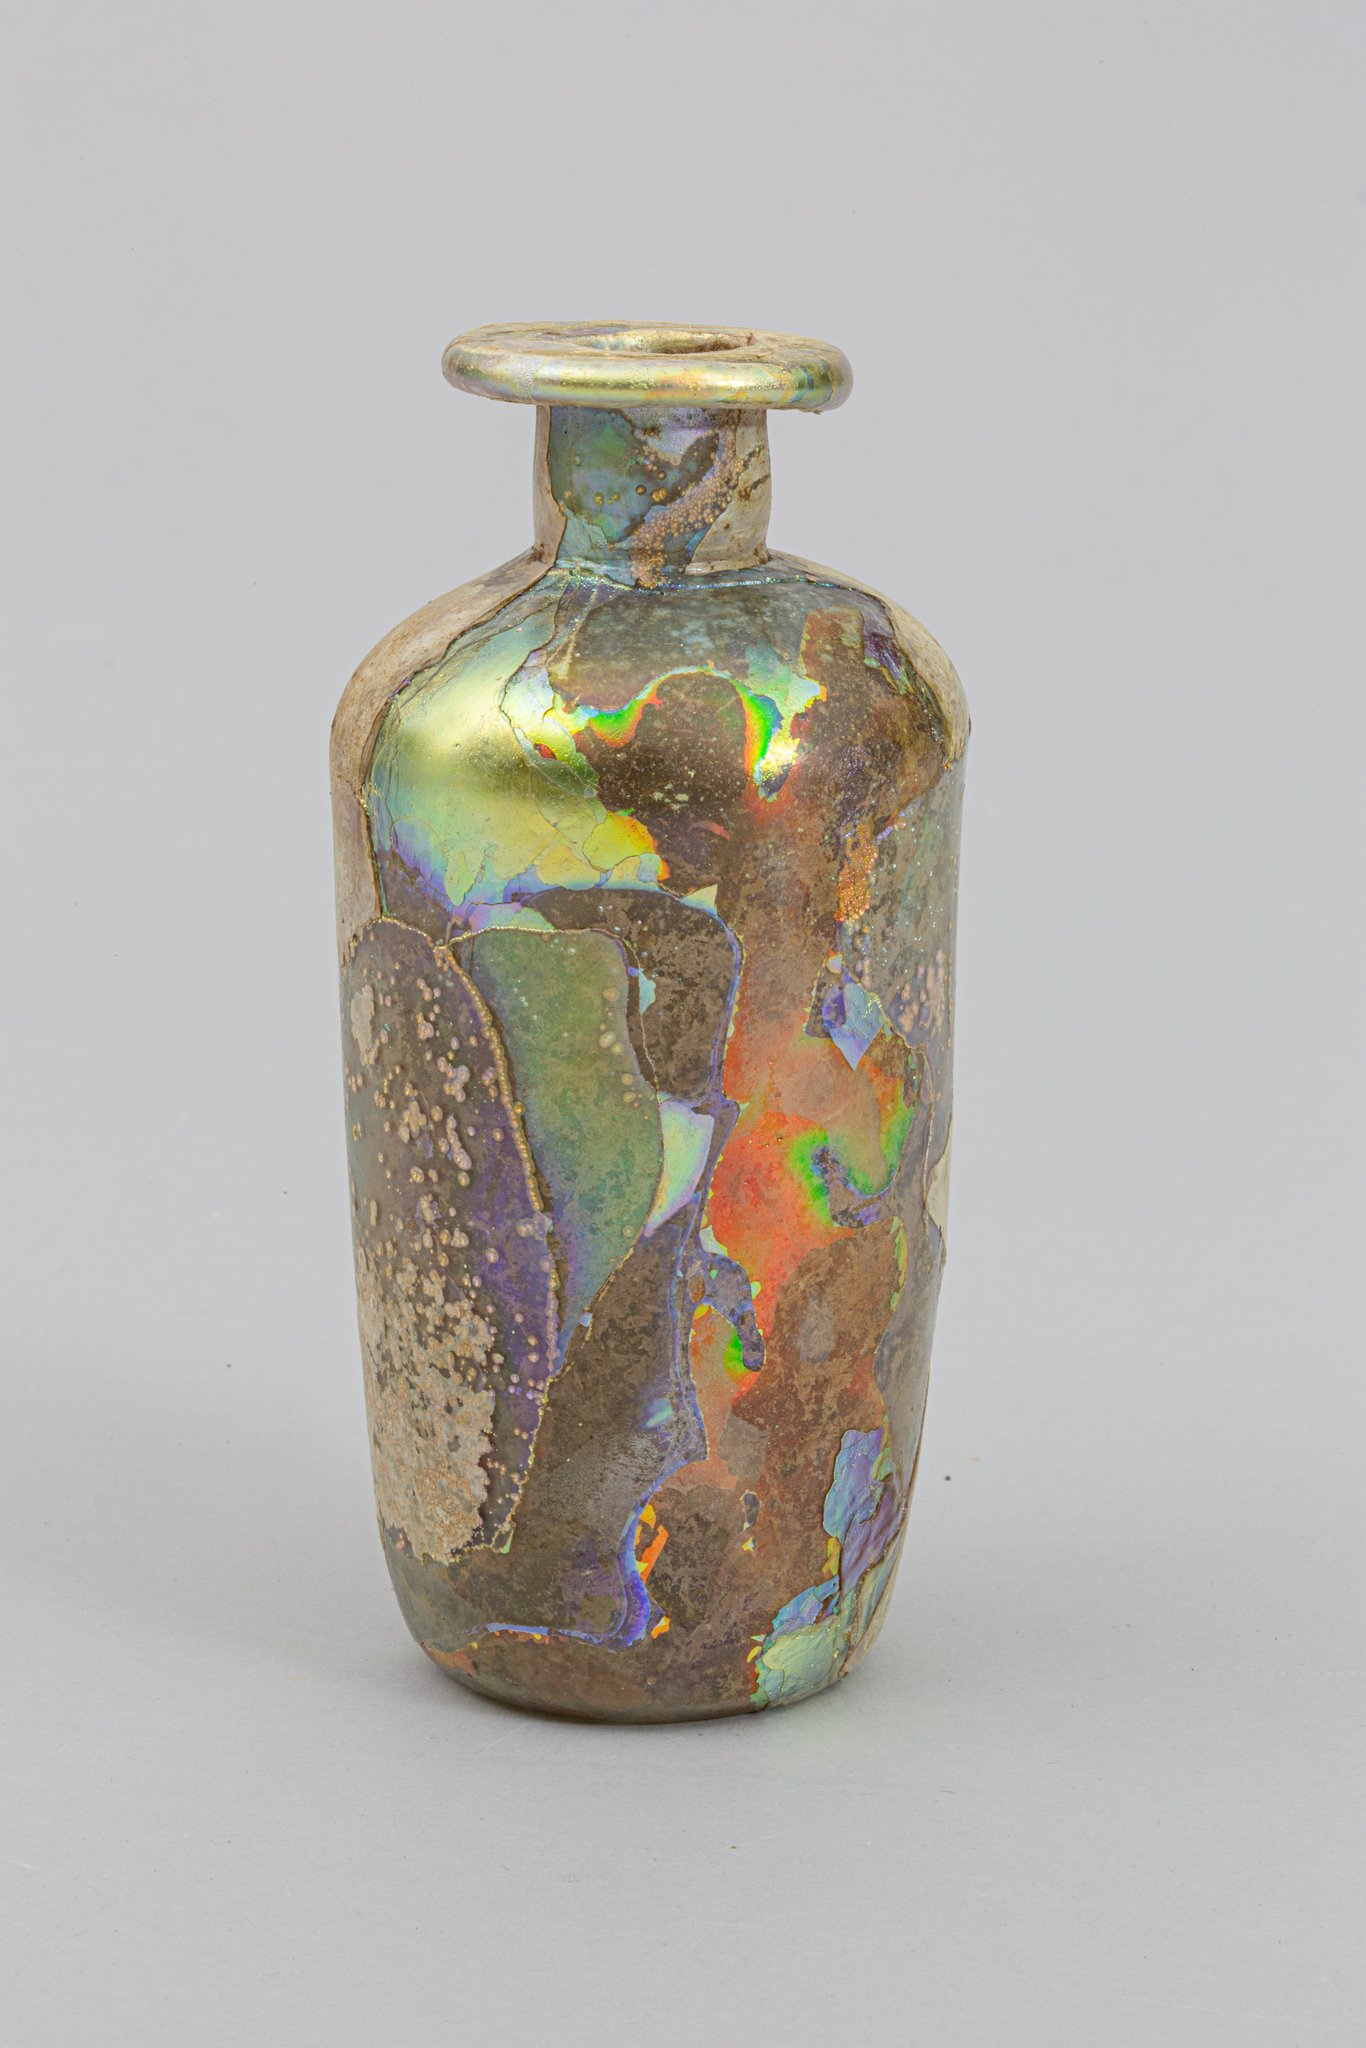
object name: bottle, cylindrical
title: Glass cylindrical bottle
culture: roman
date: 67-200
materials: glass